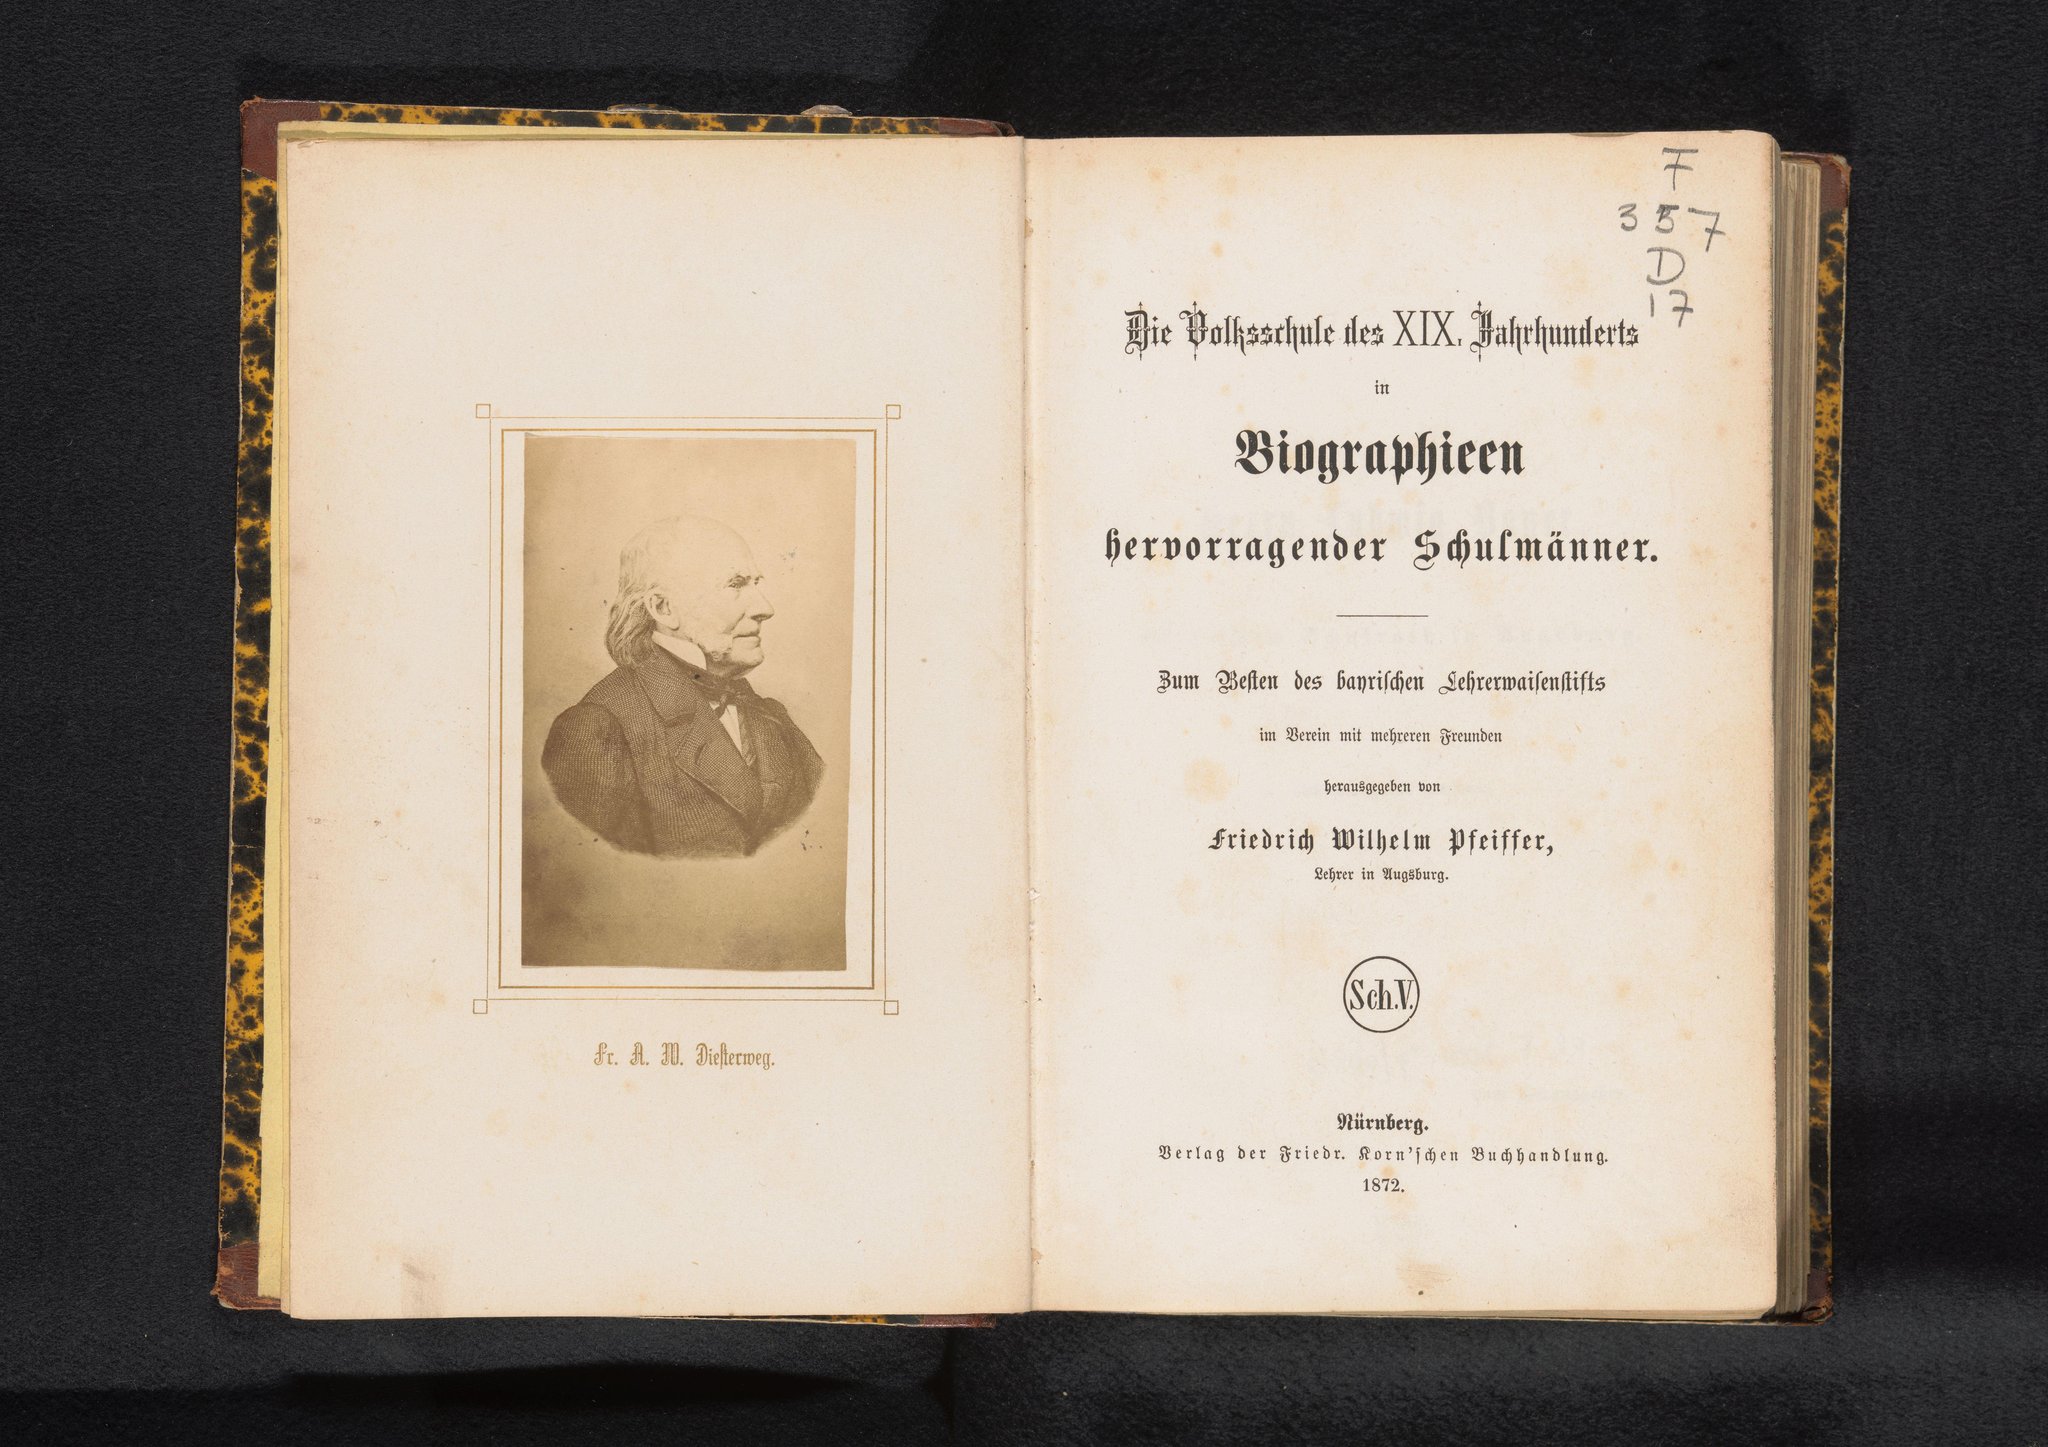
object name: photograph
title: Portret van Adolph Diesterweg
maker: Anonymous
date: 1860-1866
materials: photographic support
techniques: albumen print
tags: berlin, adult man, politician, e.g. party leader